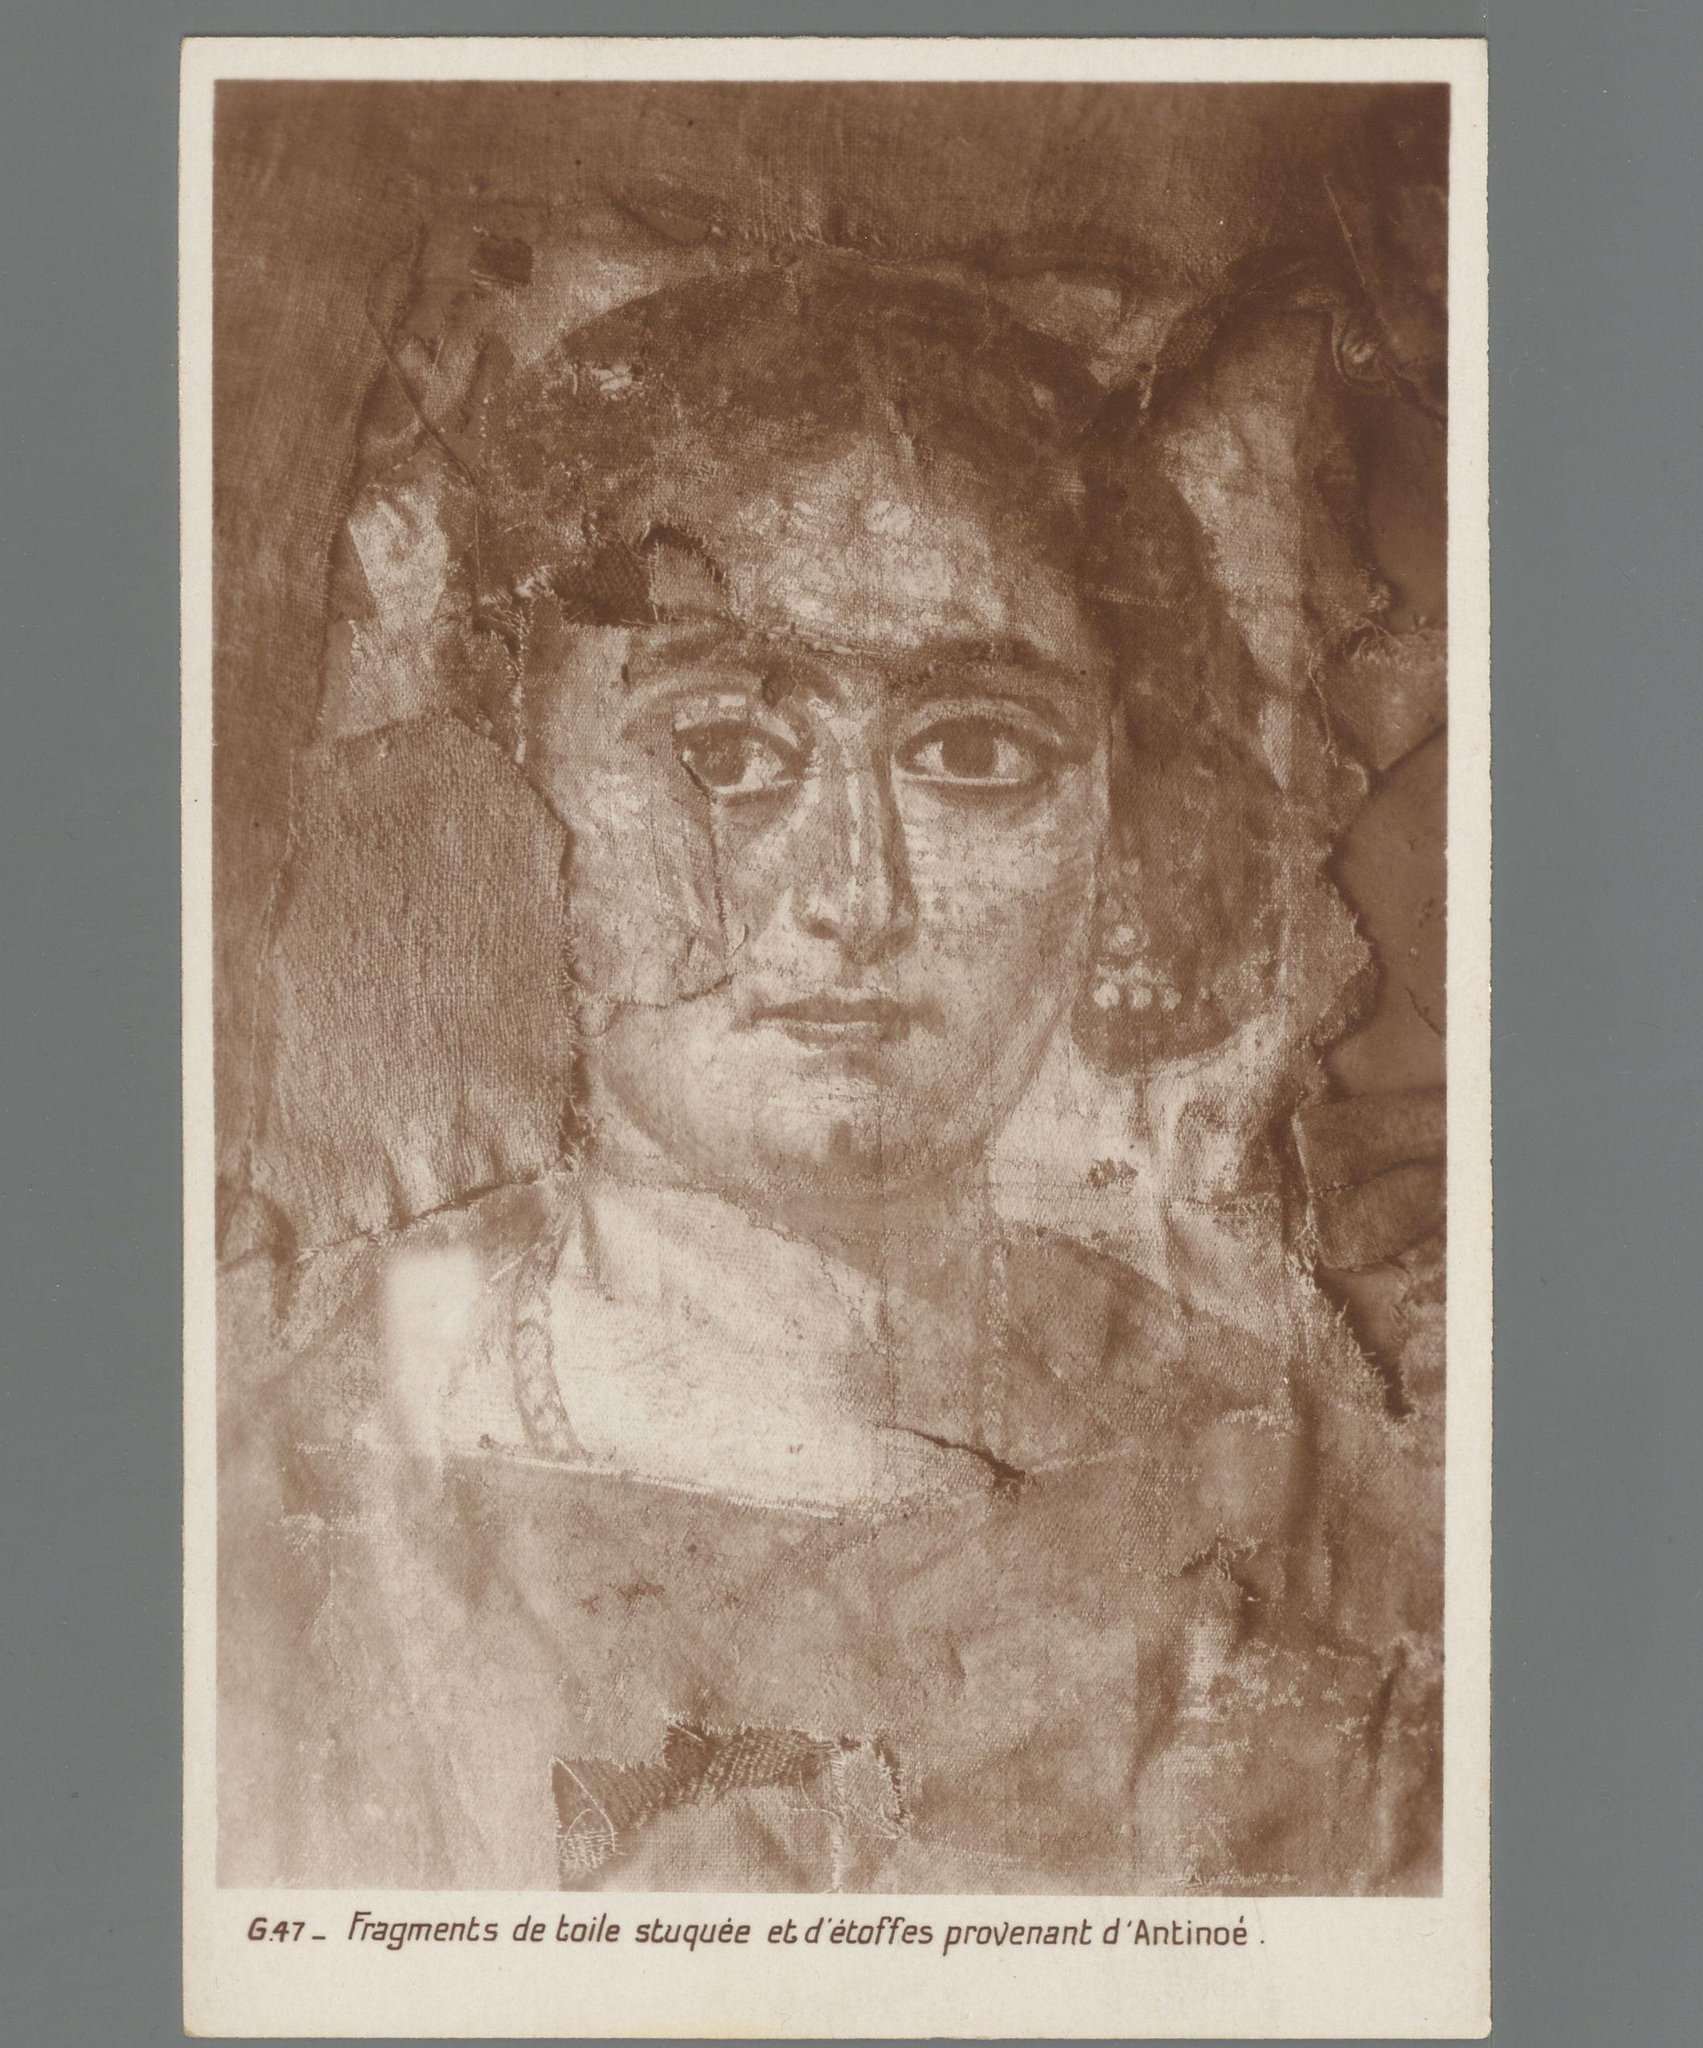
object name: photograph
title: Fragments de toile stuquée et d'étoffes provenant d'Antinoé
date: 1903-1930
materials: paper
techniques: gelatin silver print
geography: france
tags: picture, painting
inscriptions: collector's mark: ‘AFE v S’